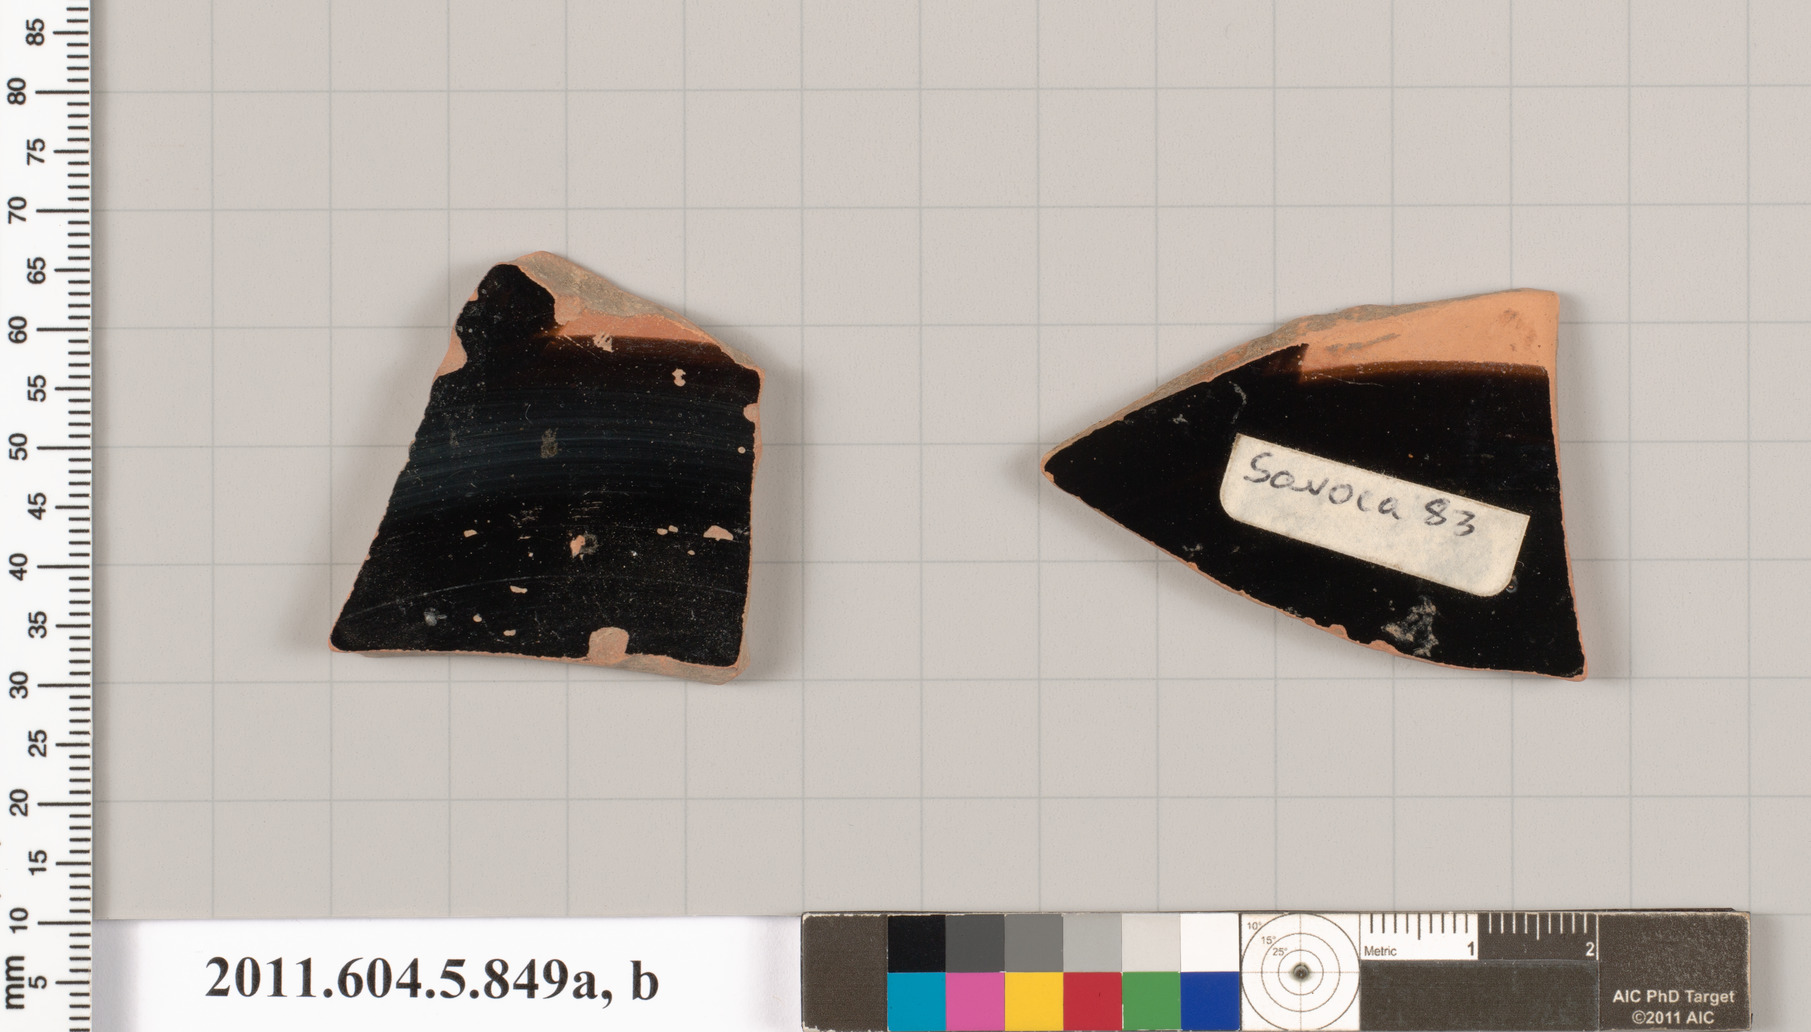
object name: kylix fragment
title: Terracotta fragments of kylikes (drinking cups)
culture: greek, attic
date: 600-401 BCE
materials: terracotta